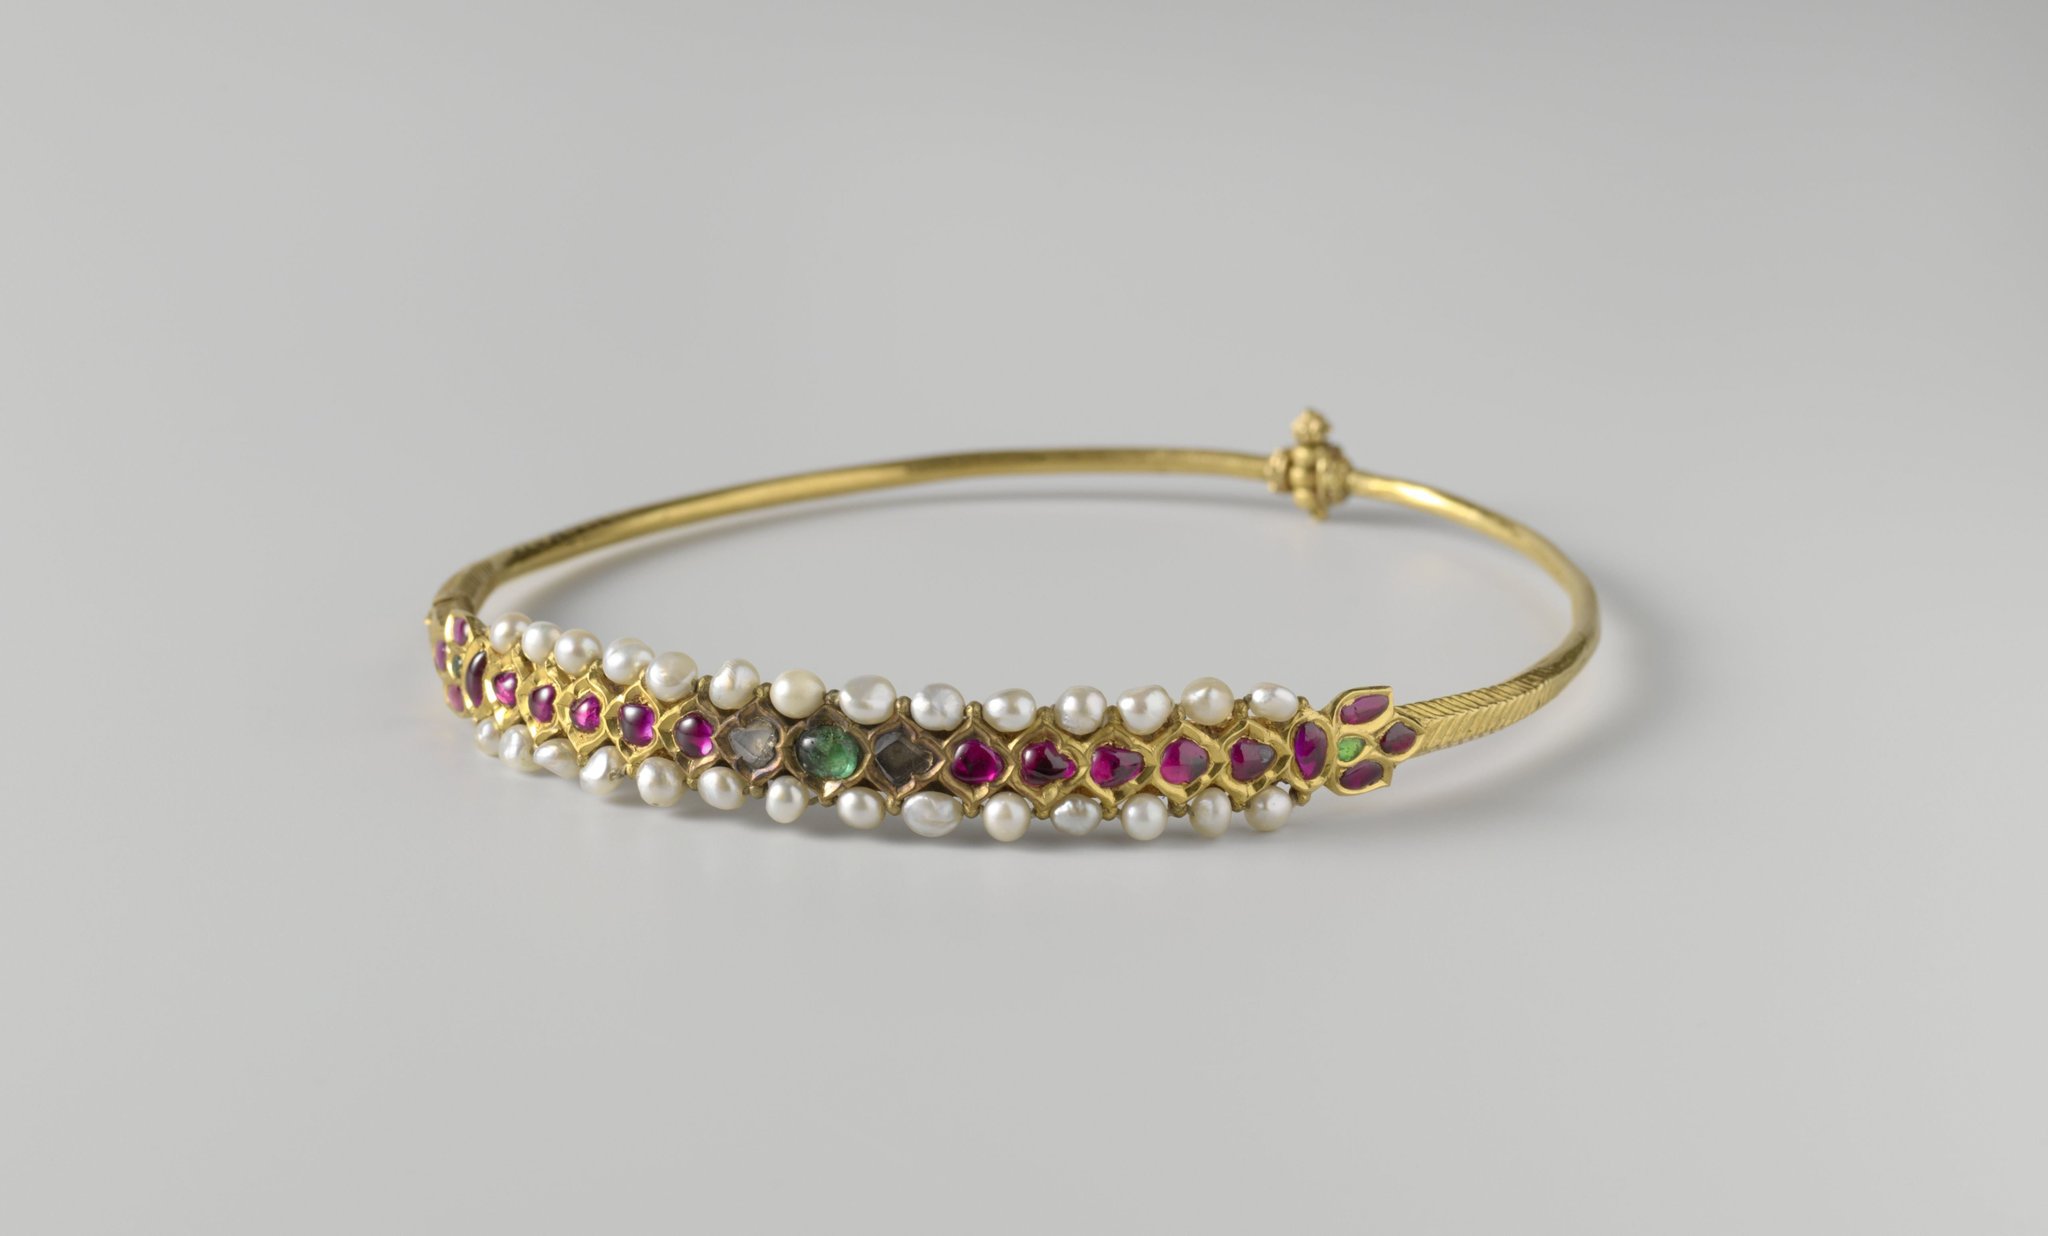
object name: halsketting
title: Pair of Bracelets and Two Necklaces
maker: Anonymous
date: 1750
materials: diamond, gold, pearl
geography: surat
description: These jewels are part of a group of gold and silver ornaments from Surat, that are now kept in the Rijksmuseum. They were collected in the 18th century by a VOC (Dutch East India Company) servant. In India gold jewels were regularly melted down in order to make new, fashionable ornaments. Consequently, Indian jewels from before the 19th century are exceptionally rare.